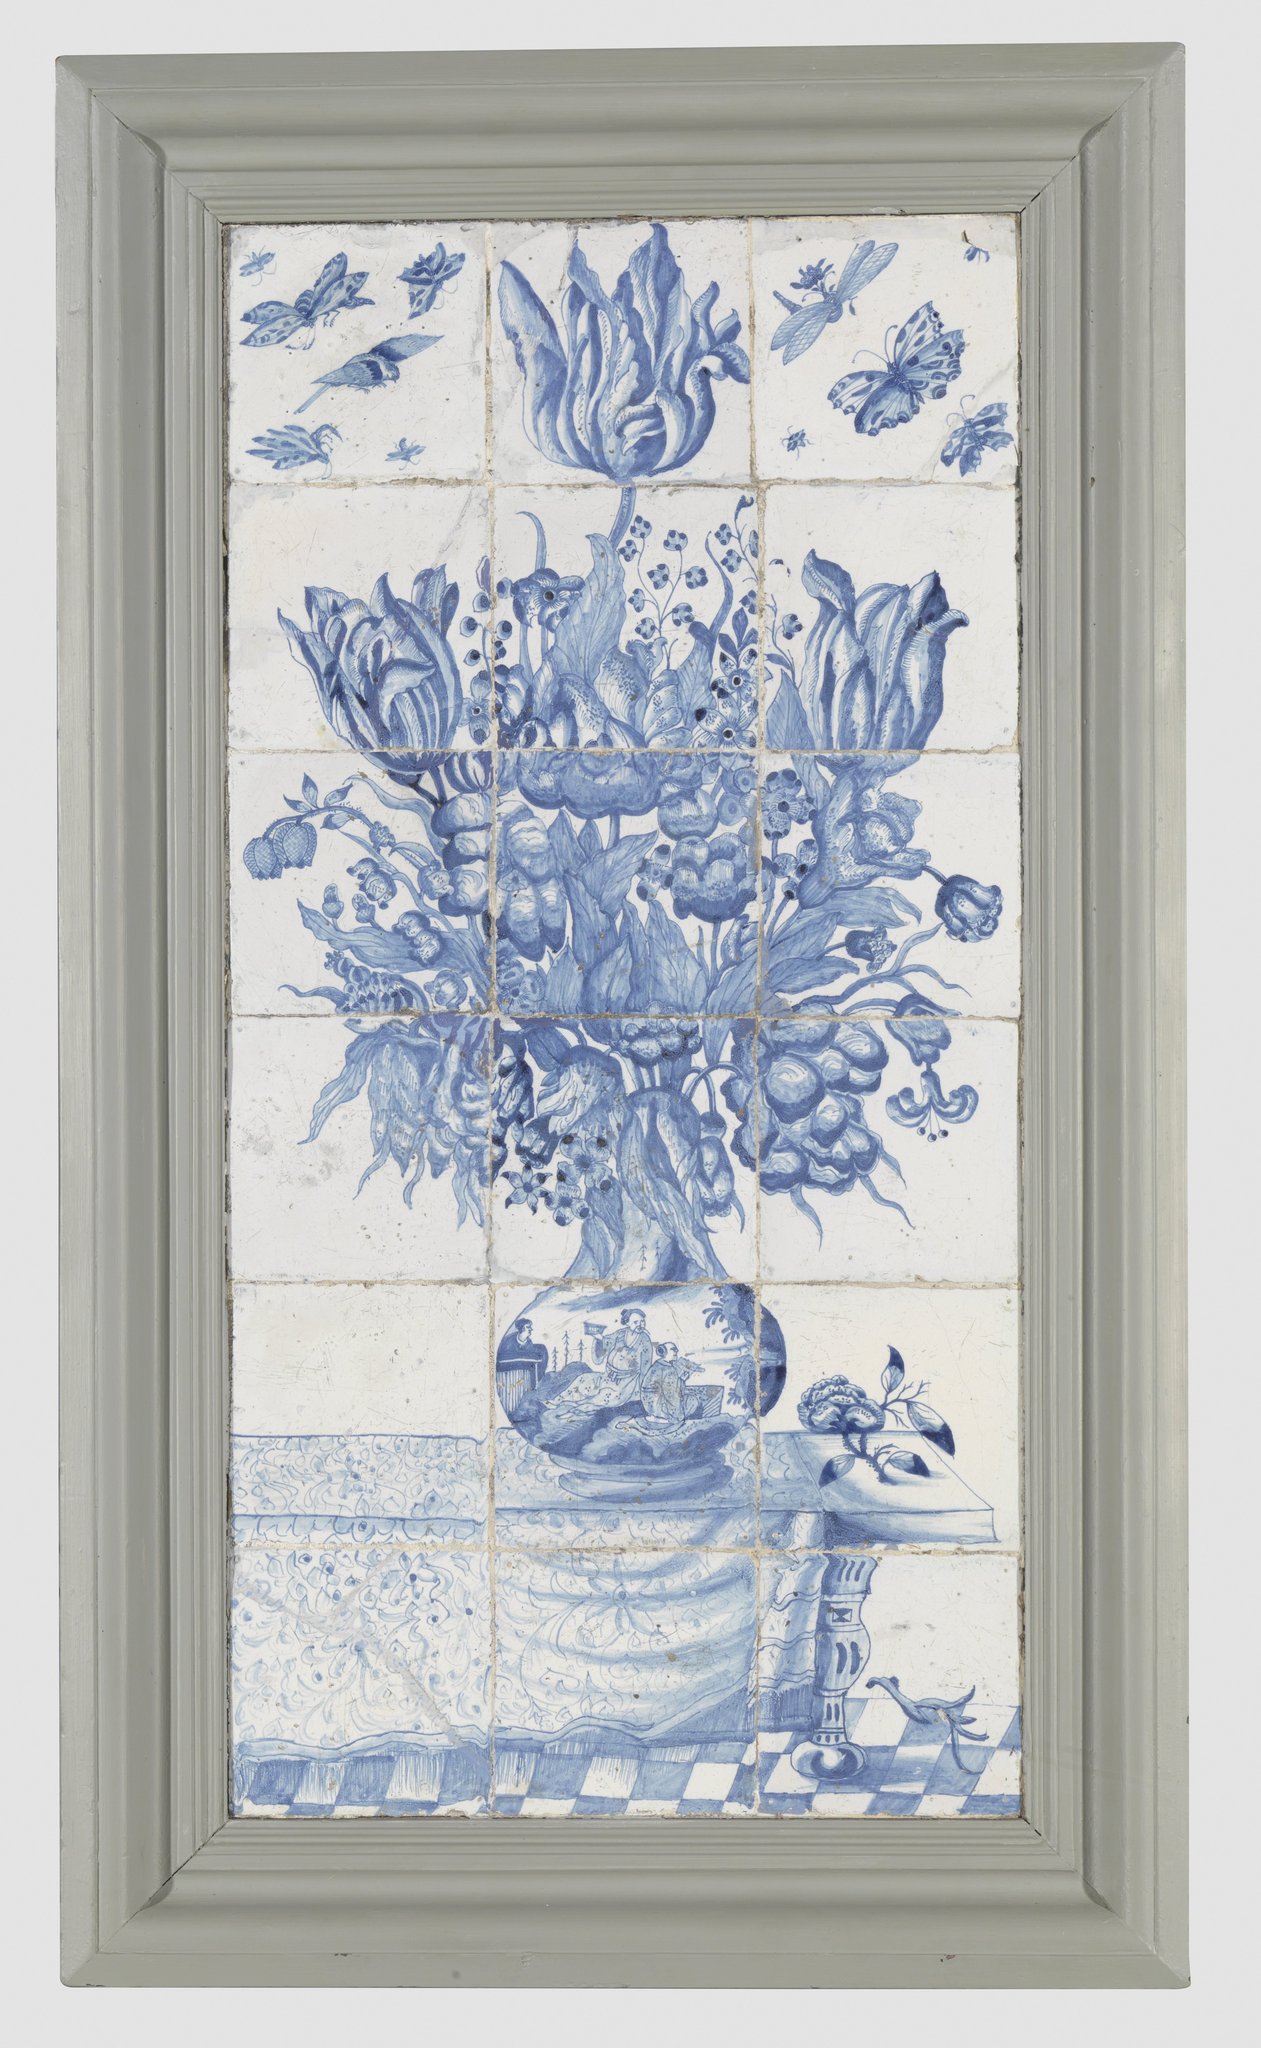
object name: tile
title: Tegeltableau van achttien tegels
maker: Anonymous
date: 1650-1700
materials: earthenware, glaze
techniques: maiolica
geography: netherlands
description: Tegeltableau van 18 tegels (6 x 3) met een blauwe geschilderde oosterse vaas met bloemen op een laag tafeltje. Aan de bovenkant insecten.